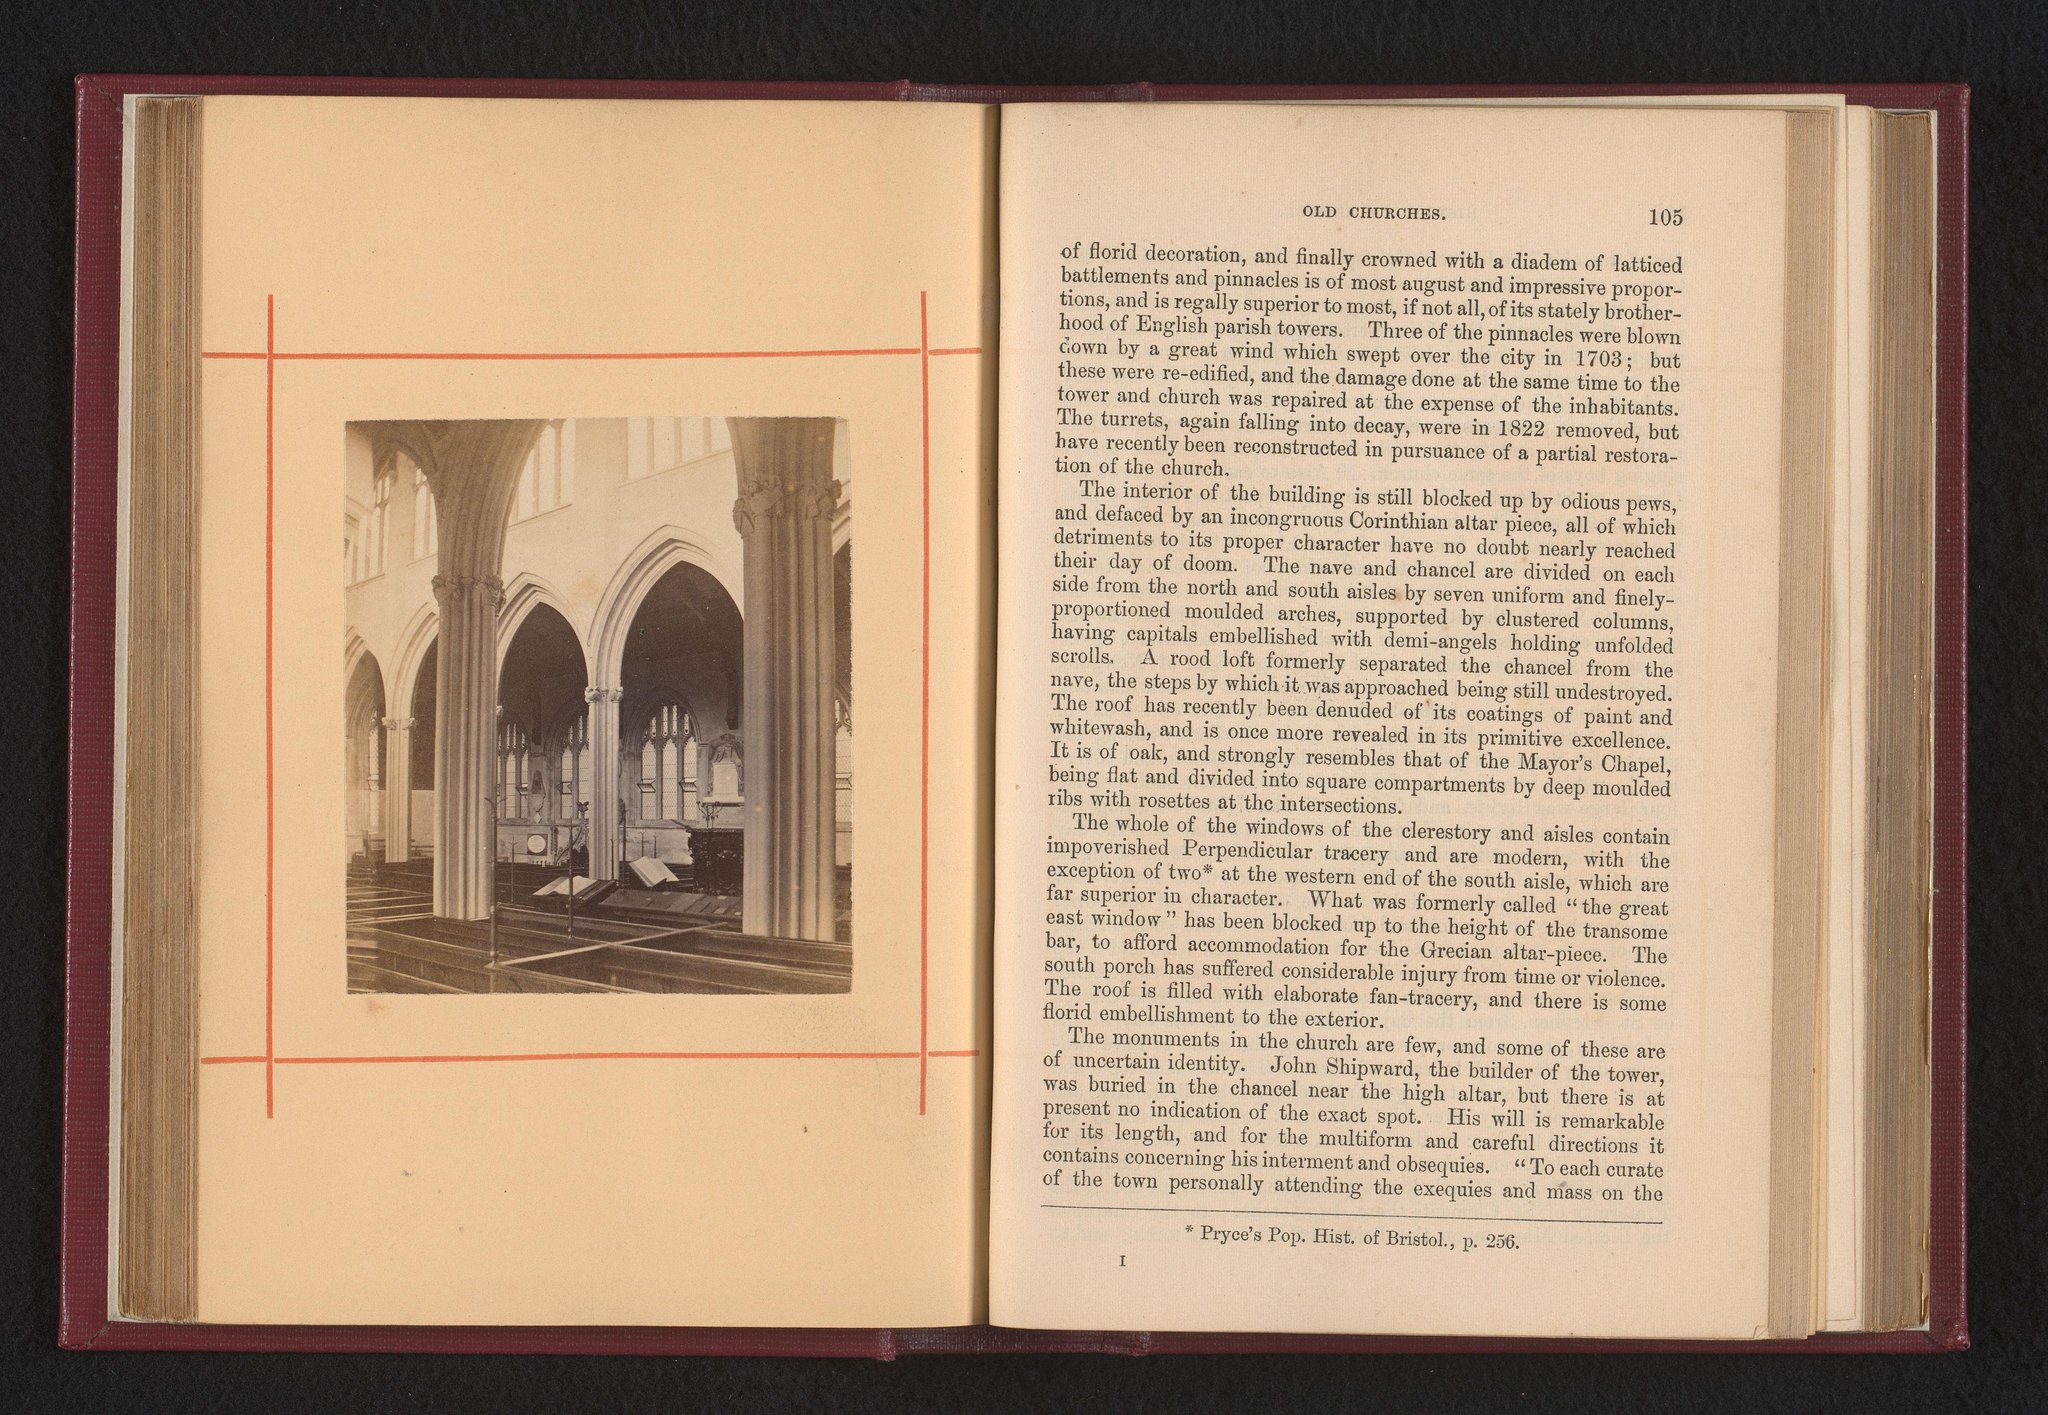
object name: photograph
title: Gezicht op het interieur van St Stephen's Church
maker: Anonymous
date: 1867-1872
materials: photographic support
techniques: albumen print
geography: bristol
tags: interior of church